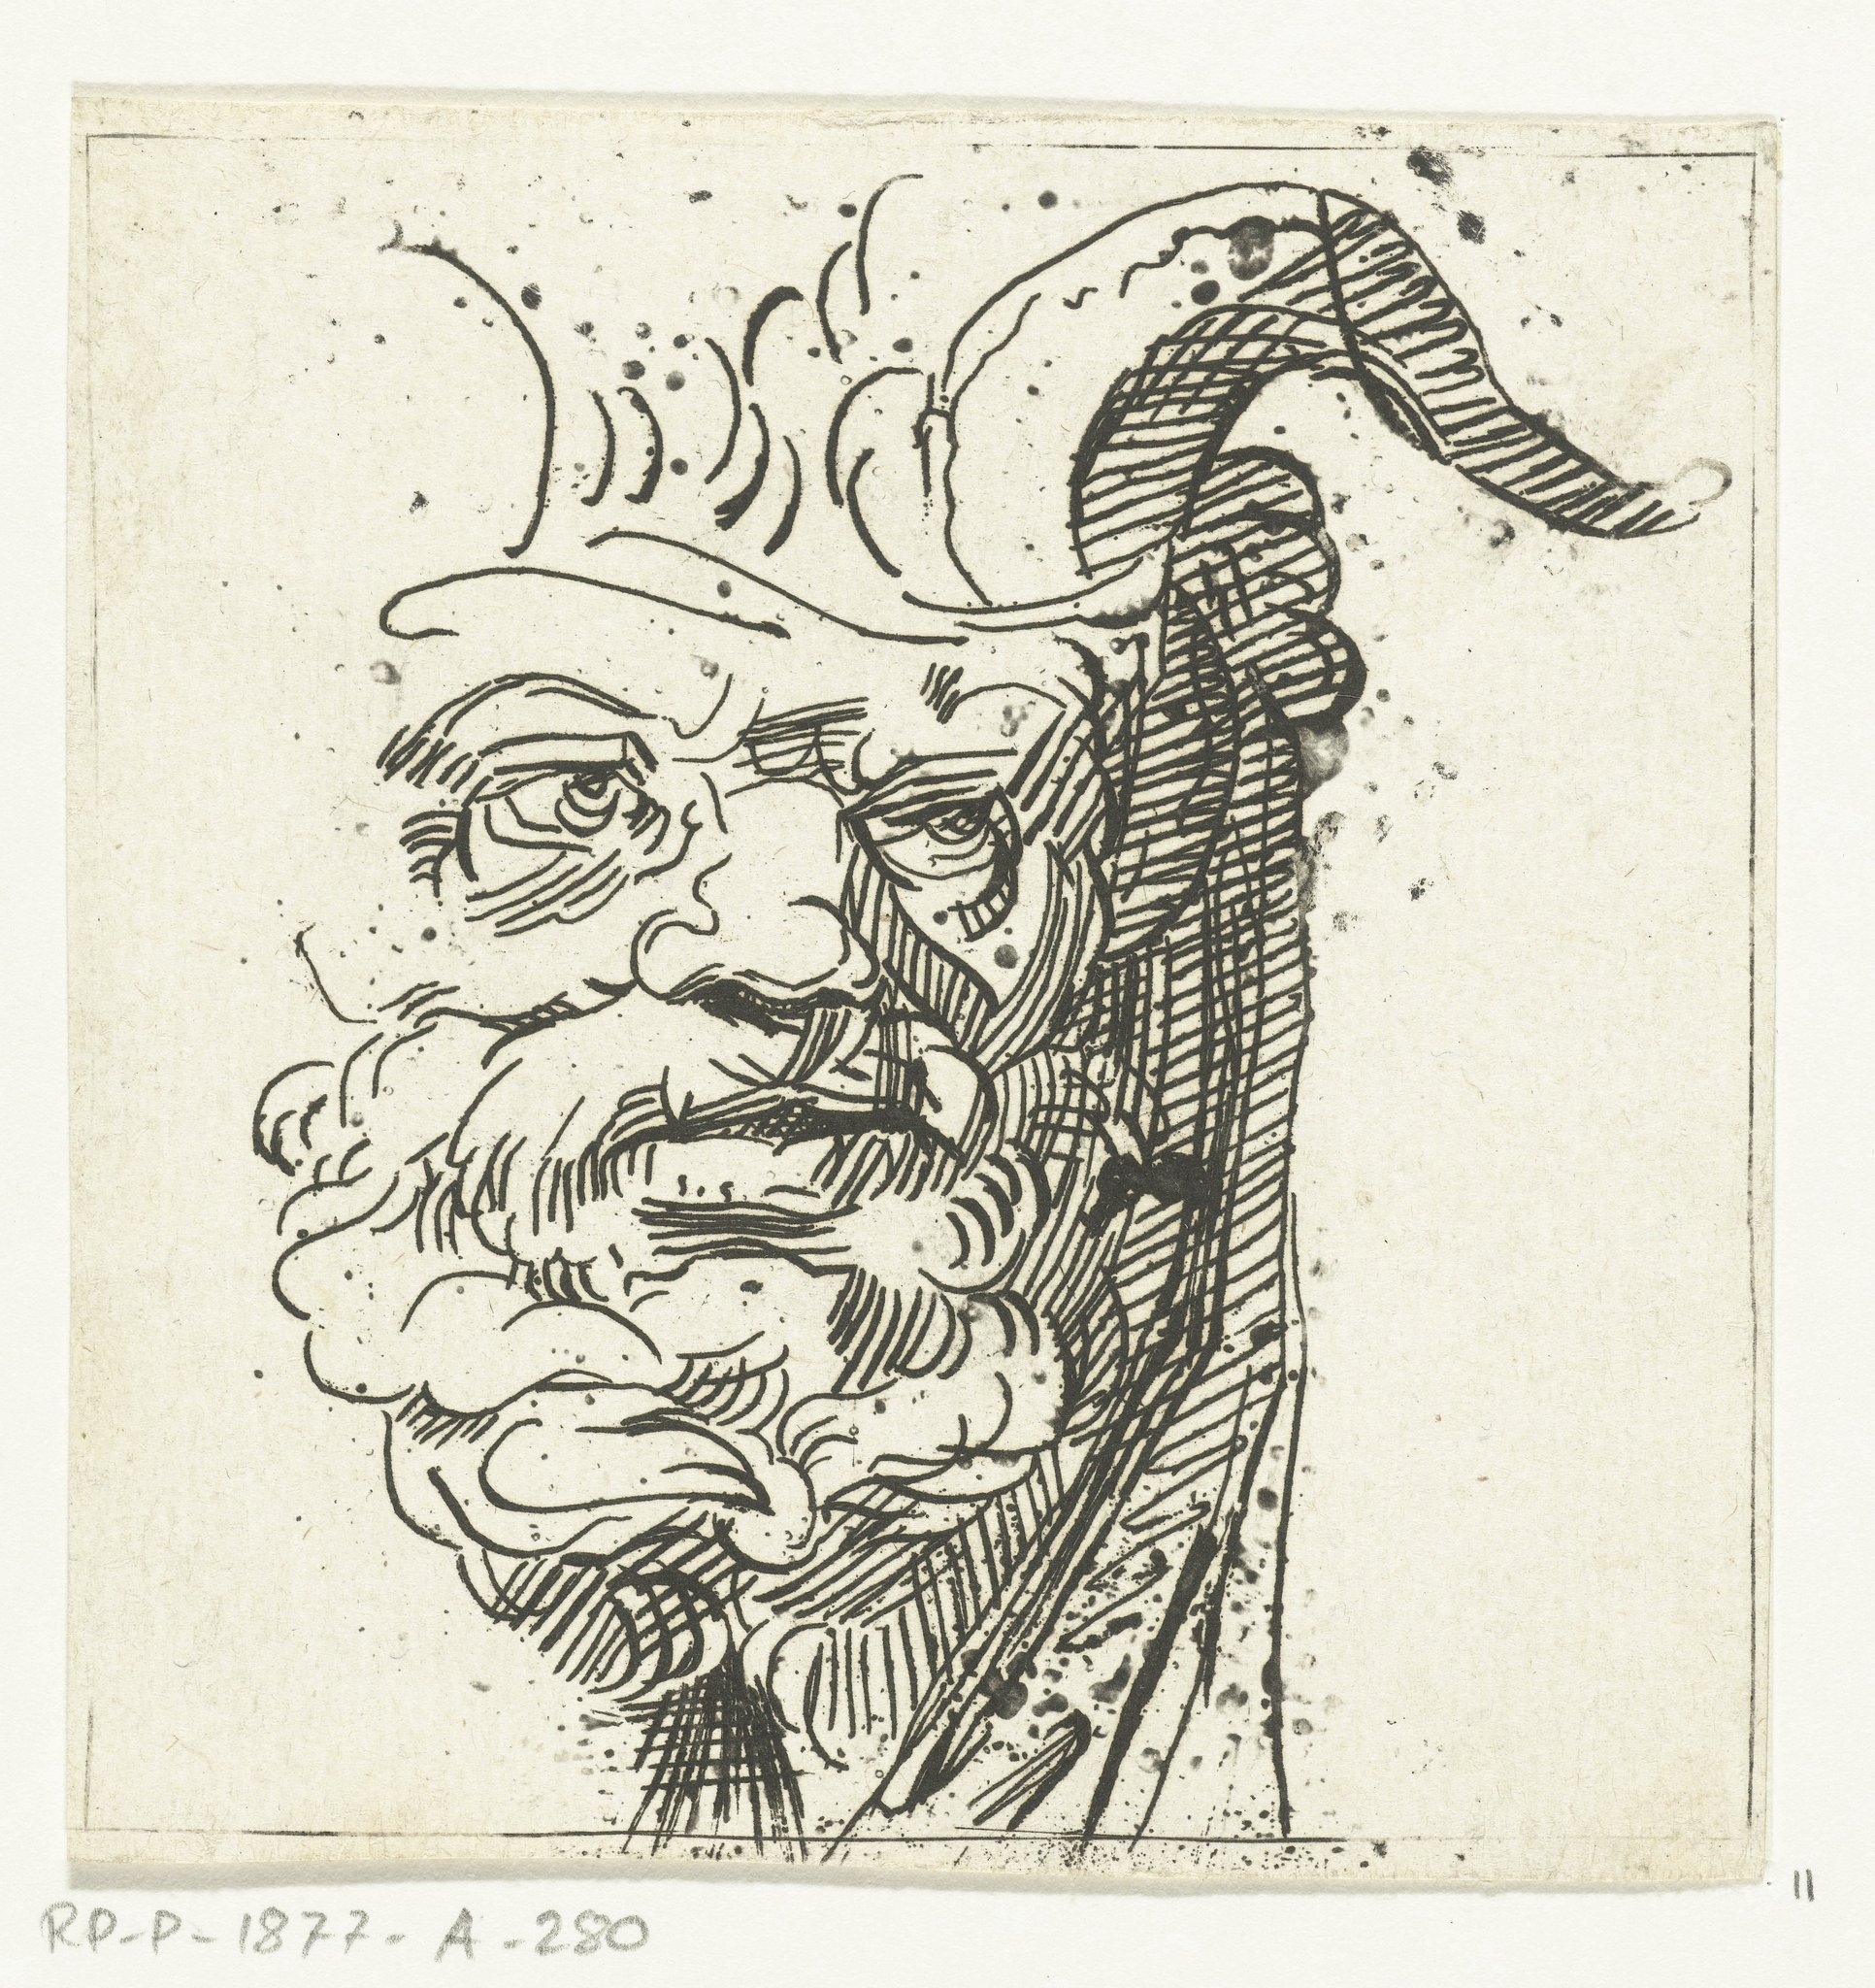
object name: print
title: Kop van een sater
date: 1778-1838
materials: paper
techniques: etching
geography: netherlands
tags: satyr(s) (in general)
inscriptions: collector's mark: Lugt 2228